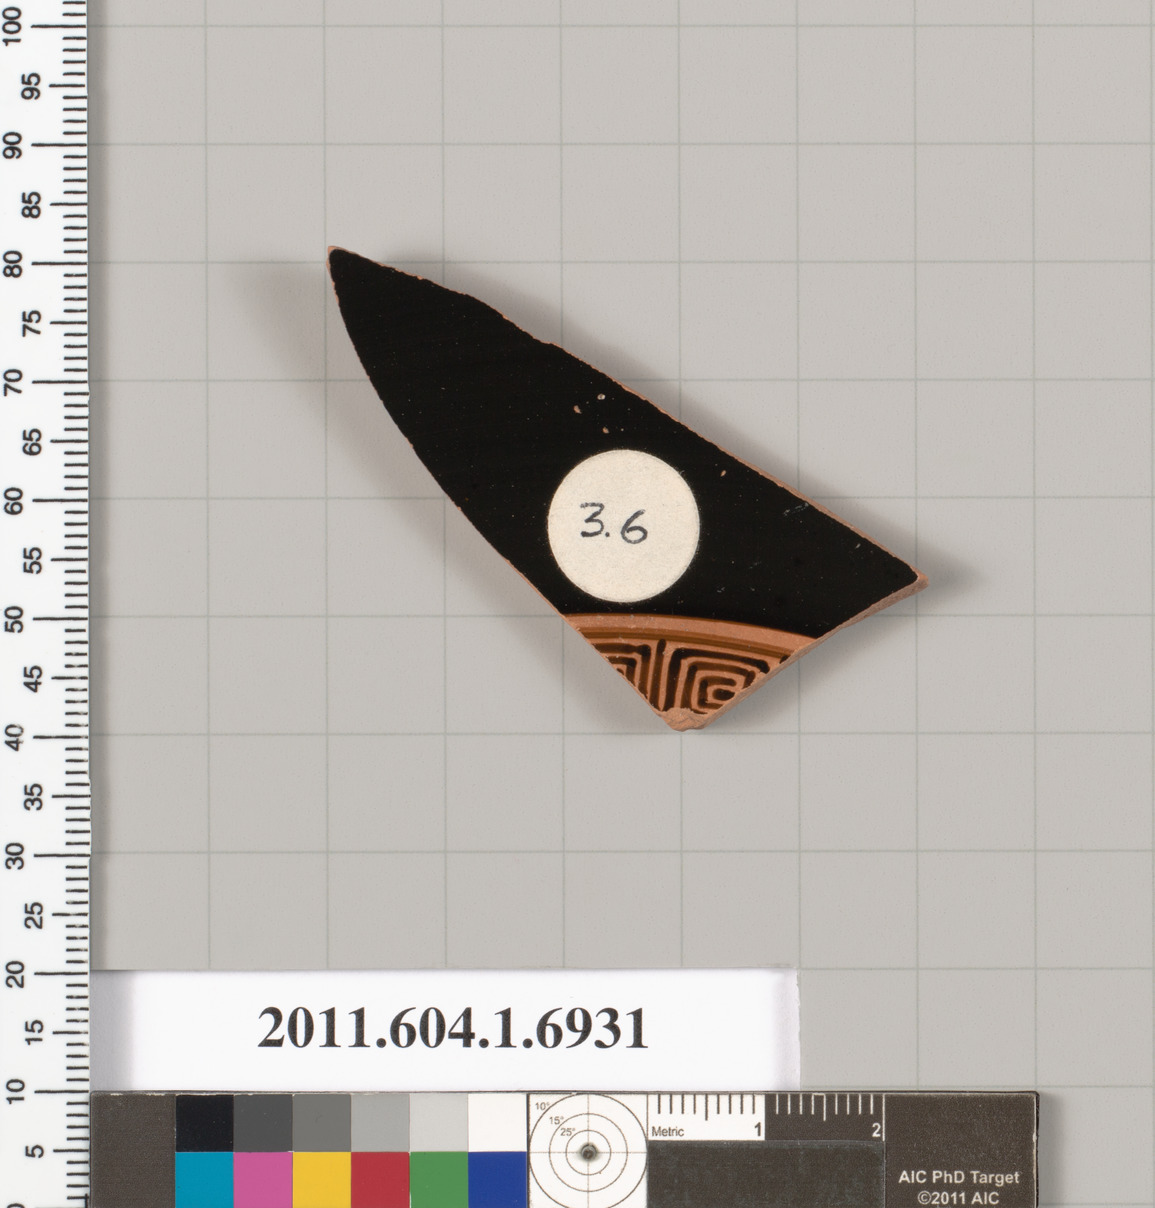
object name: kylix fragment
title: Terracotta fragment of a kylix (drinking cup)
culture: greek, attic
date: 490-470 BCE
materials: terracotta